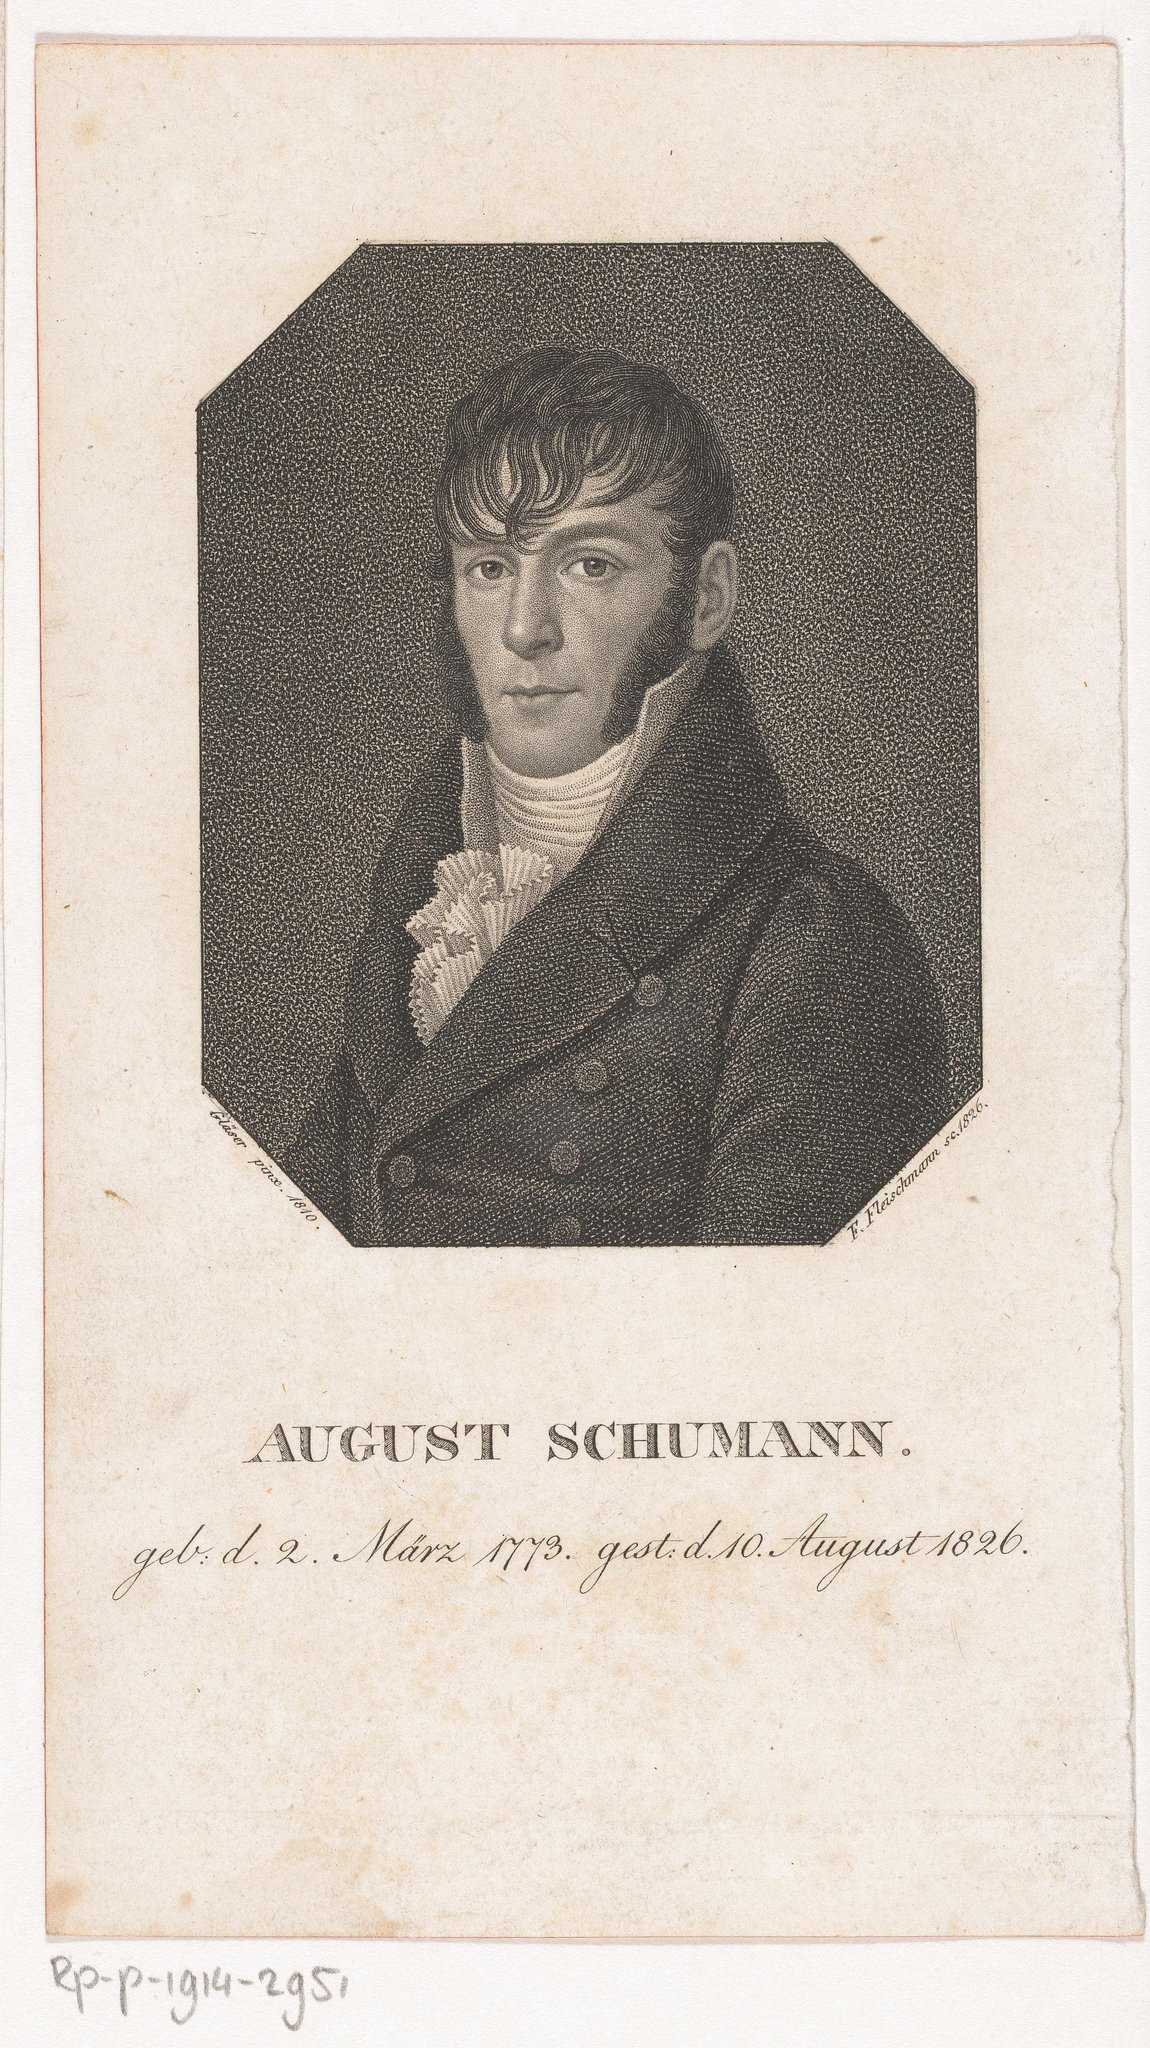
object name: print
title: Portretten van beroemde mensen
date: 1826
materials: paper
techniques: engraving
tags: zwickau, publisher, august schumann, historical persons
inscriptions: collector's mark: Lugt 2228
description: Prent afkomstig uit: 'Bildnisse der berühmtesten Menschen aller Völker und Zeiten' van de gebroeders Schumann, uitgegeven in 1818-1832 te Zwickau.